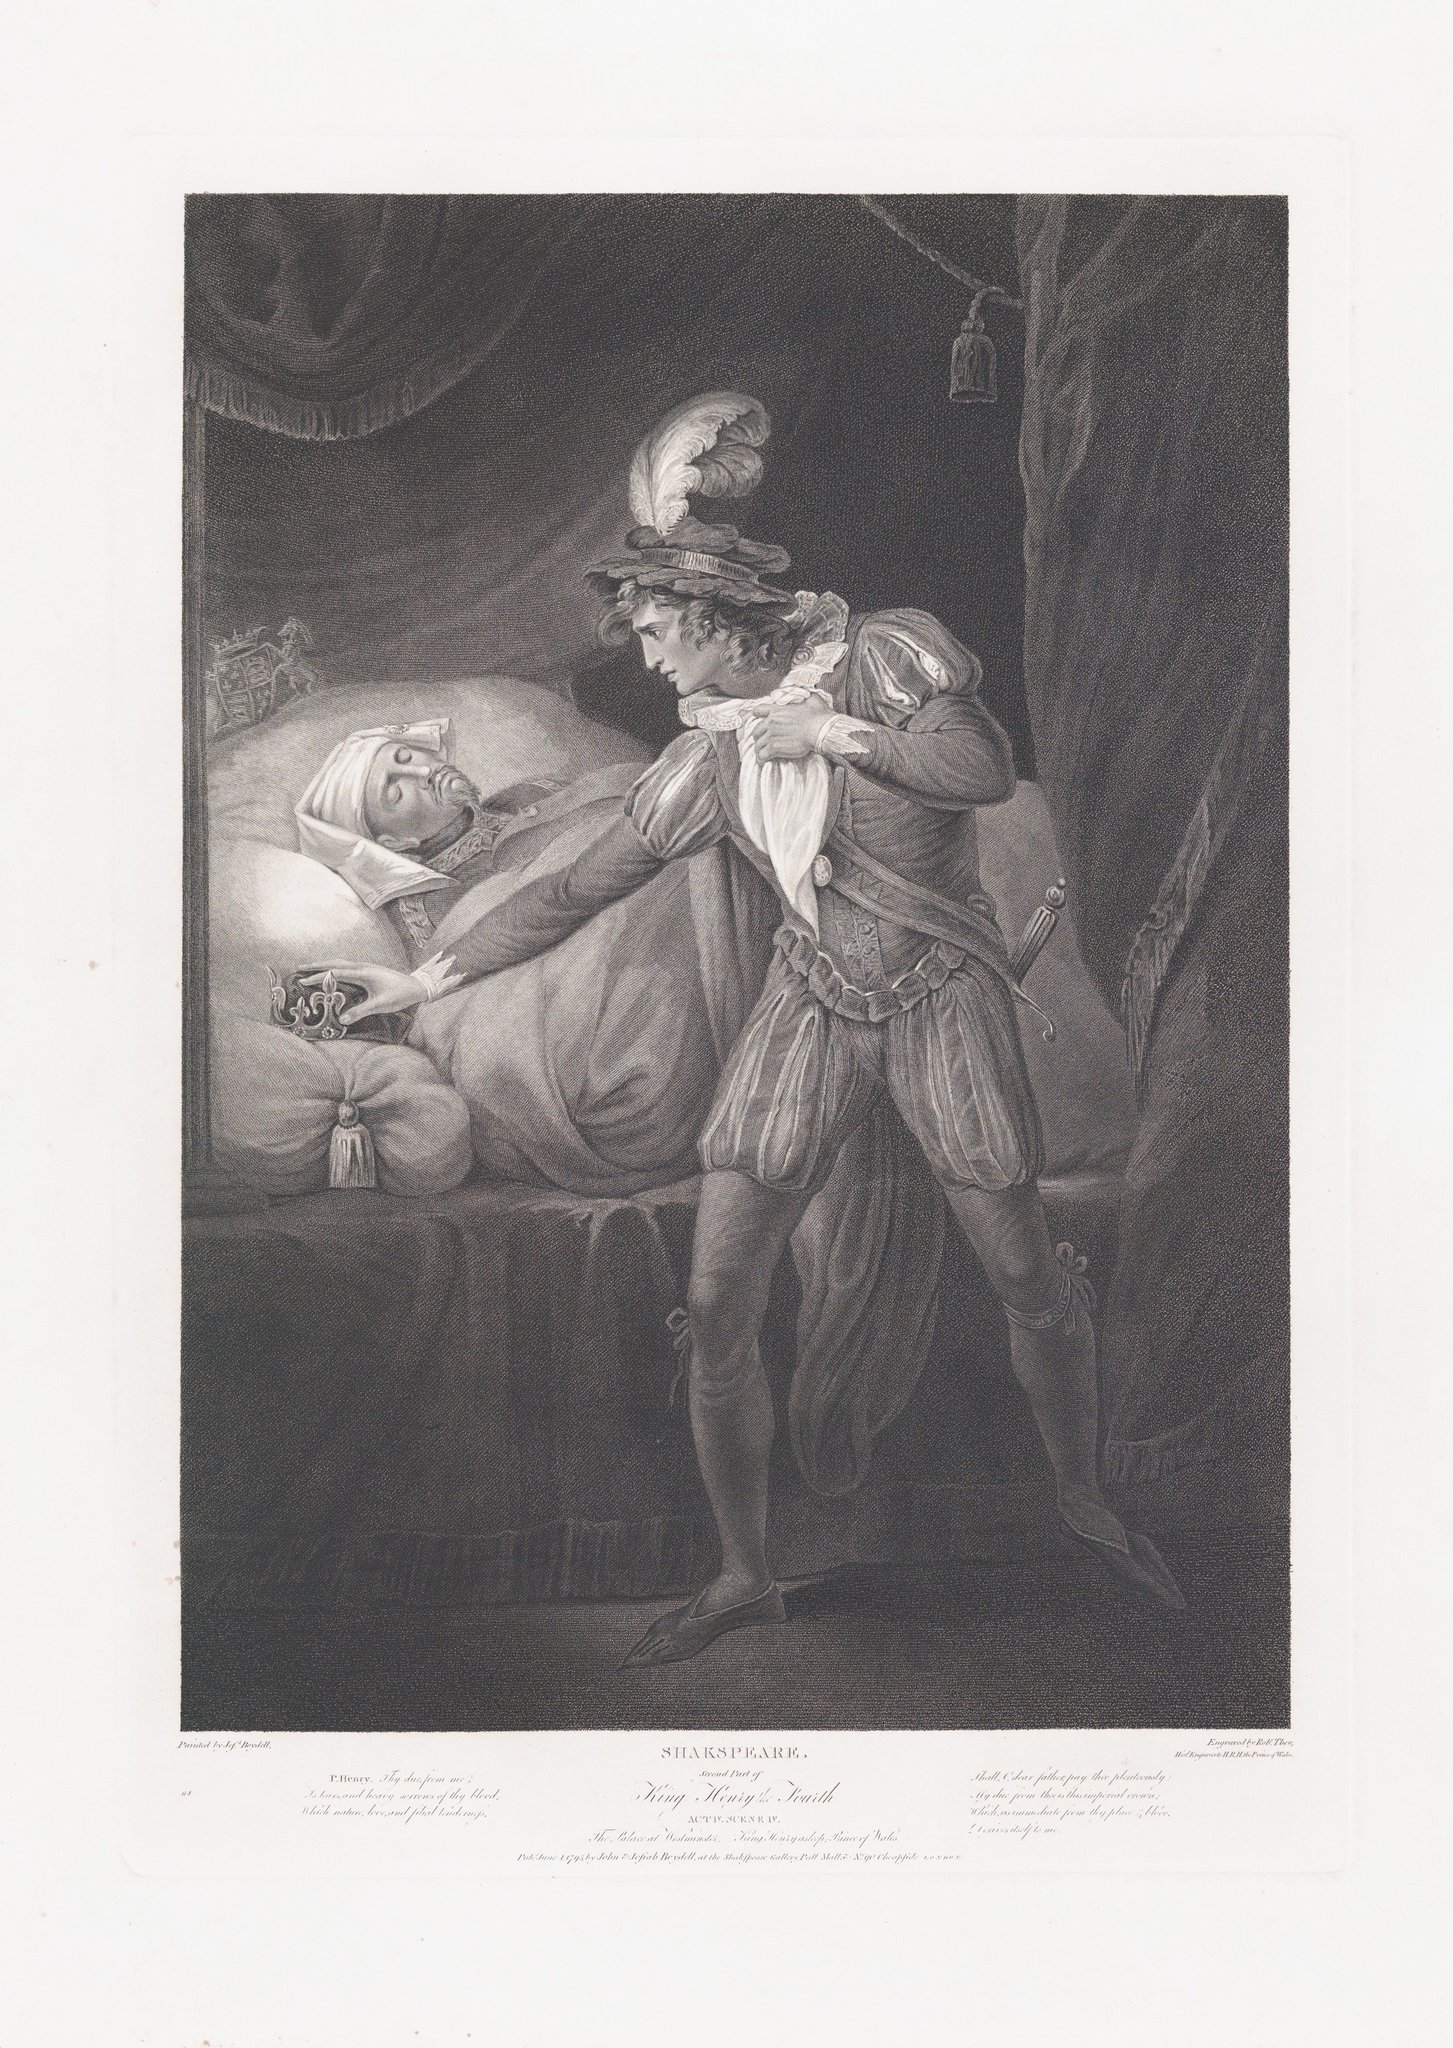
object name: print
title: The Palace at Westminster: King Henry and the Prince of Wales (Shakespeare, King Henry IV, Part 2, Act 4, Scene 4)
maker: robert thew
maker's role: engraver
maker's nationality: british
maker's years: 1758-1802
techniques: engraving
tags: kings,princes